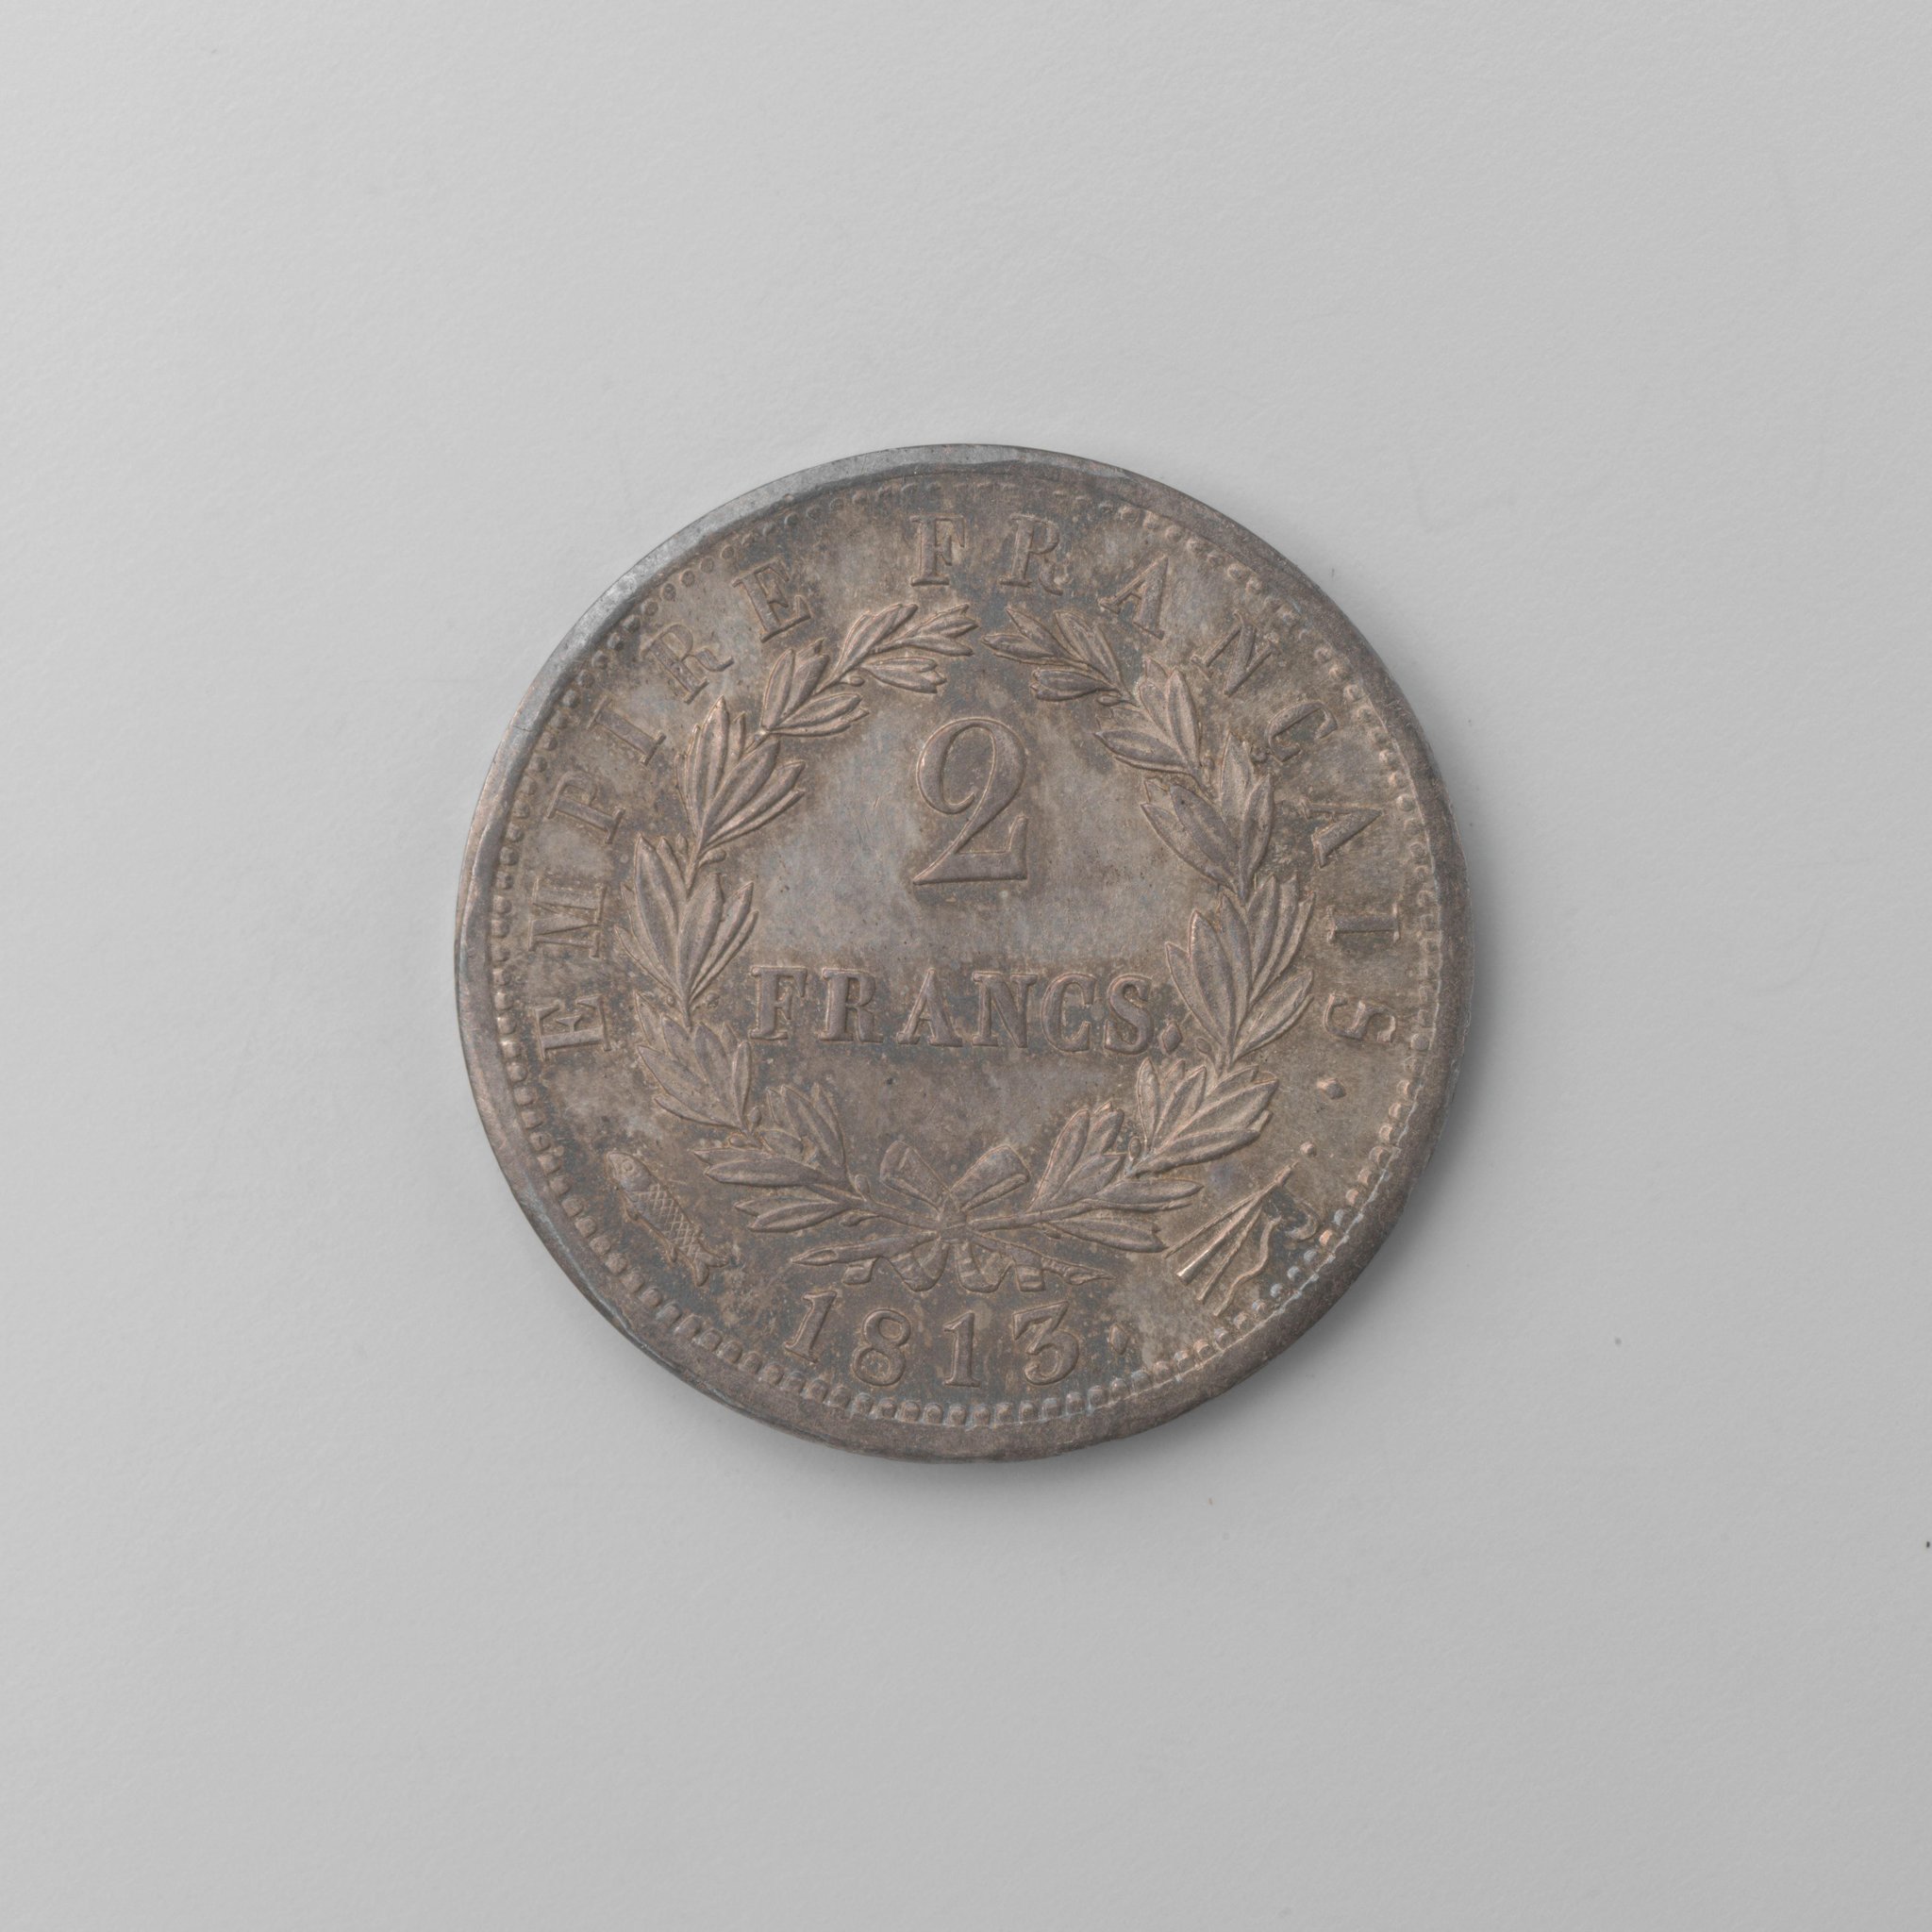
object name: coin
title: Nederlandse 2 francs, 1813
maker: napoleon i (emperor of the french)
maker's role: generaal, keizer, staatsman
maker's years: 1769-1821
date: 1813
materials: silver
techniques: striking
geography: utrecht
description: Zilveren munt. Voorzijde: gelauwerd borstbeeld van Napoleon I naar rechts. Keerzijde: binnen olijfkrans waarde-aanduiding 2 francs. Jaartal in omschrift onderaan. Randschrift.